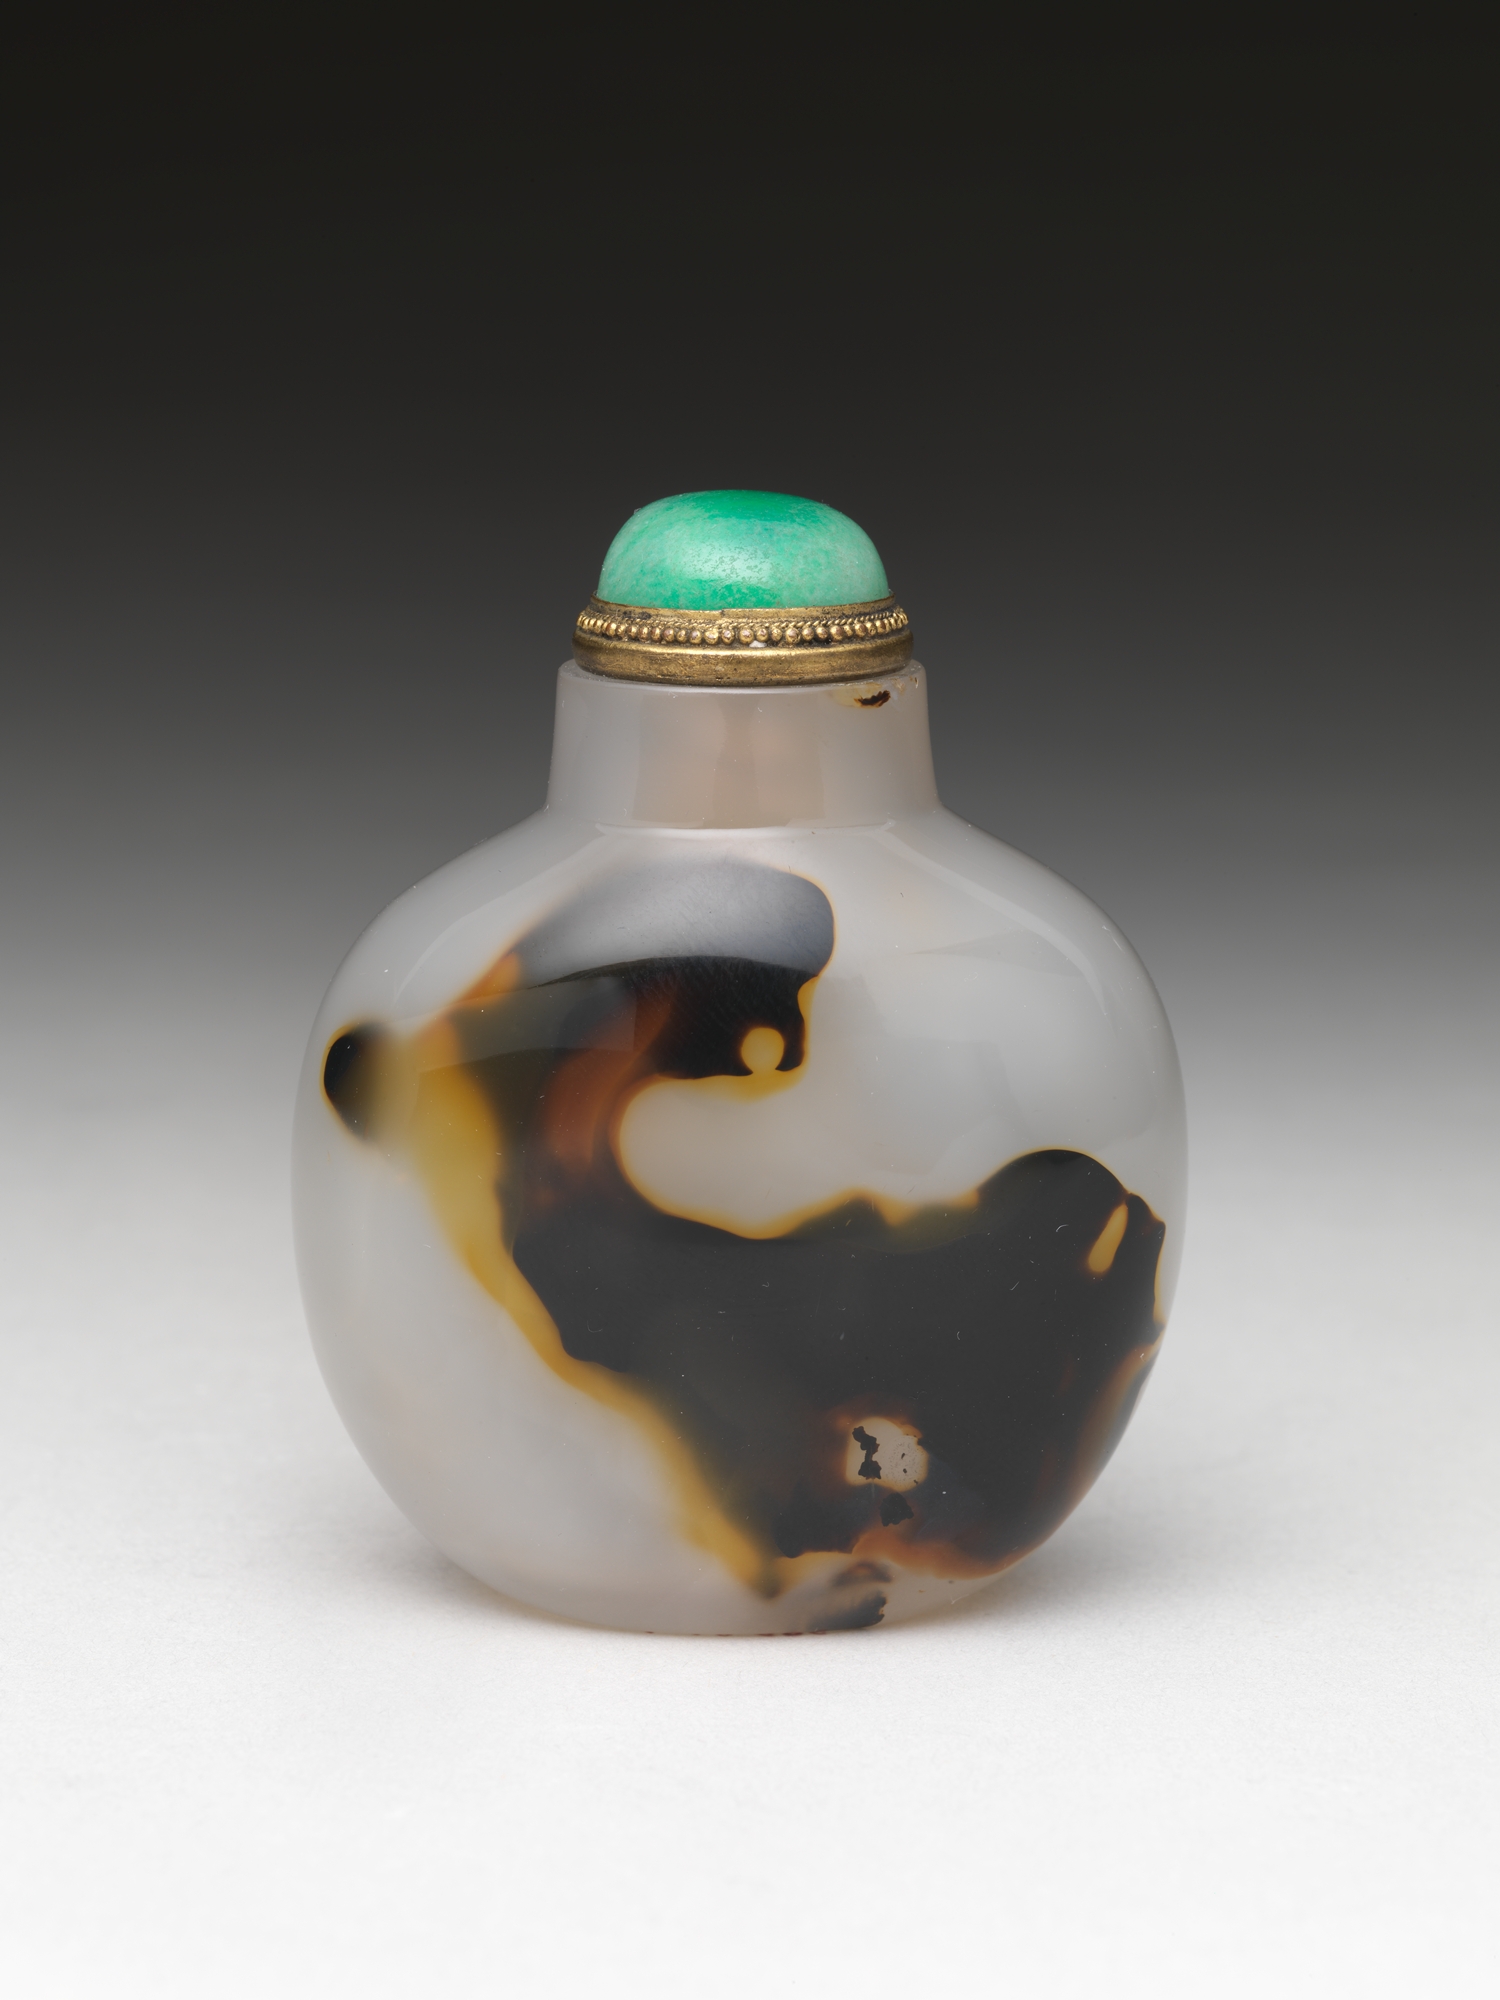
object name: snuff bottle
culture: chinese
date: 1767-1833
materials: stone